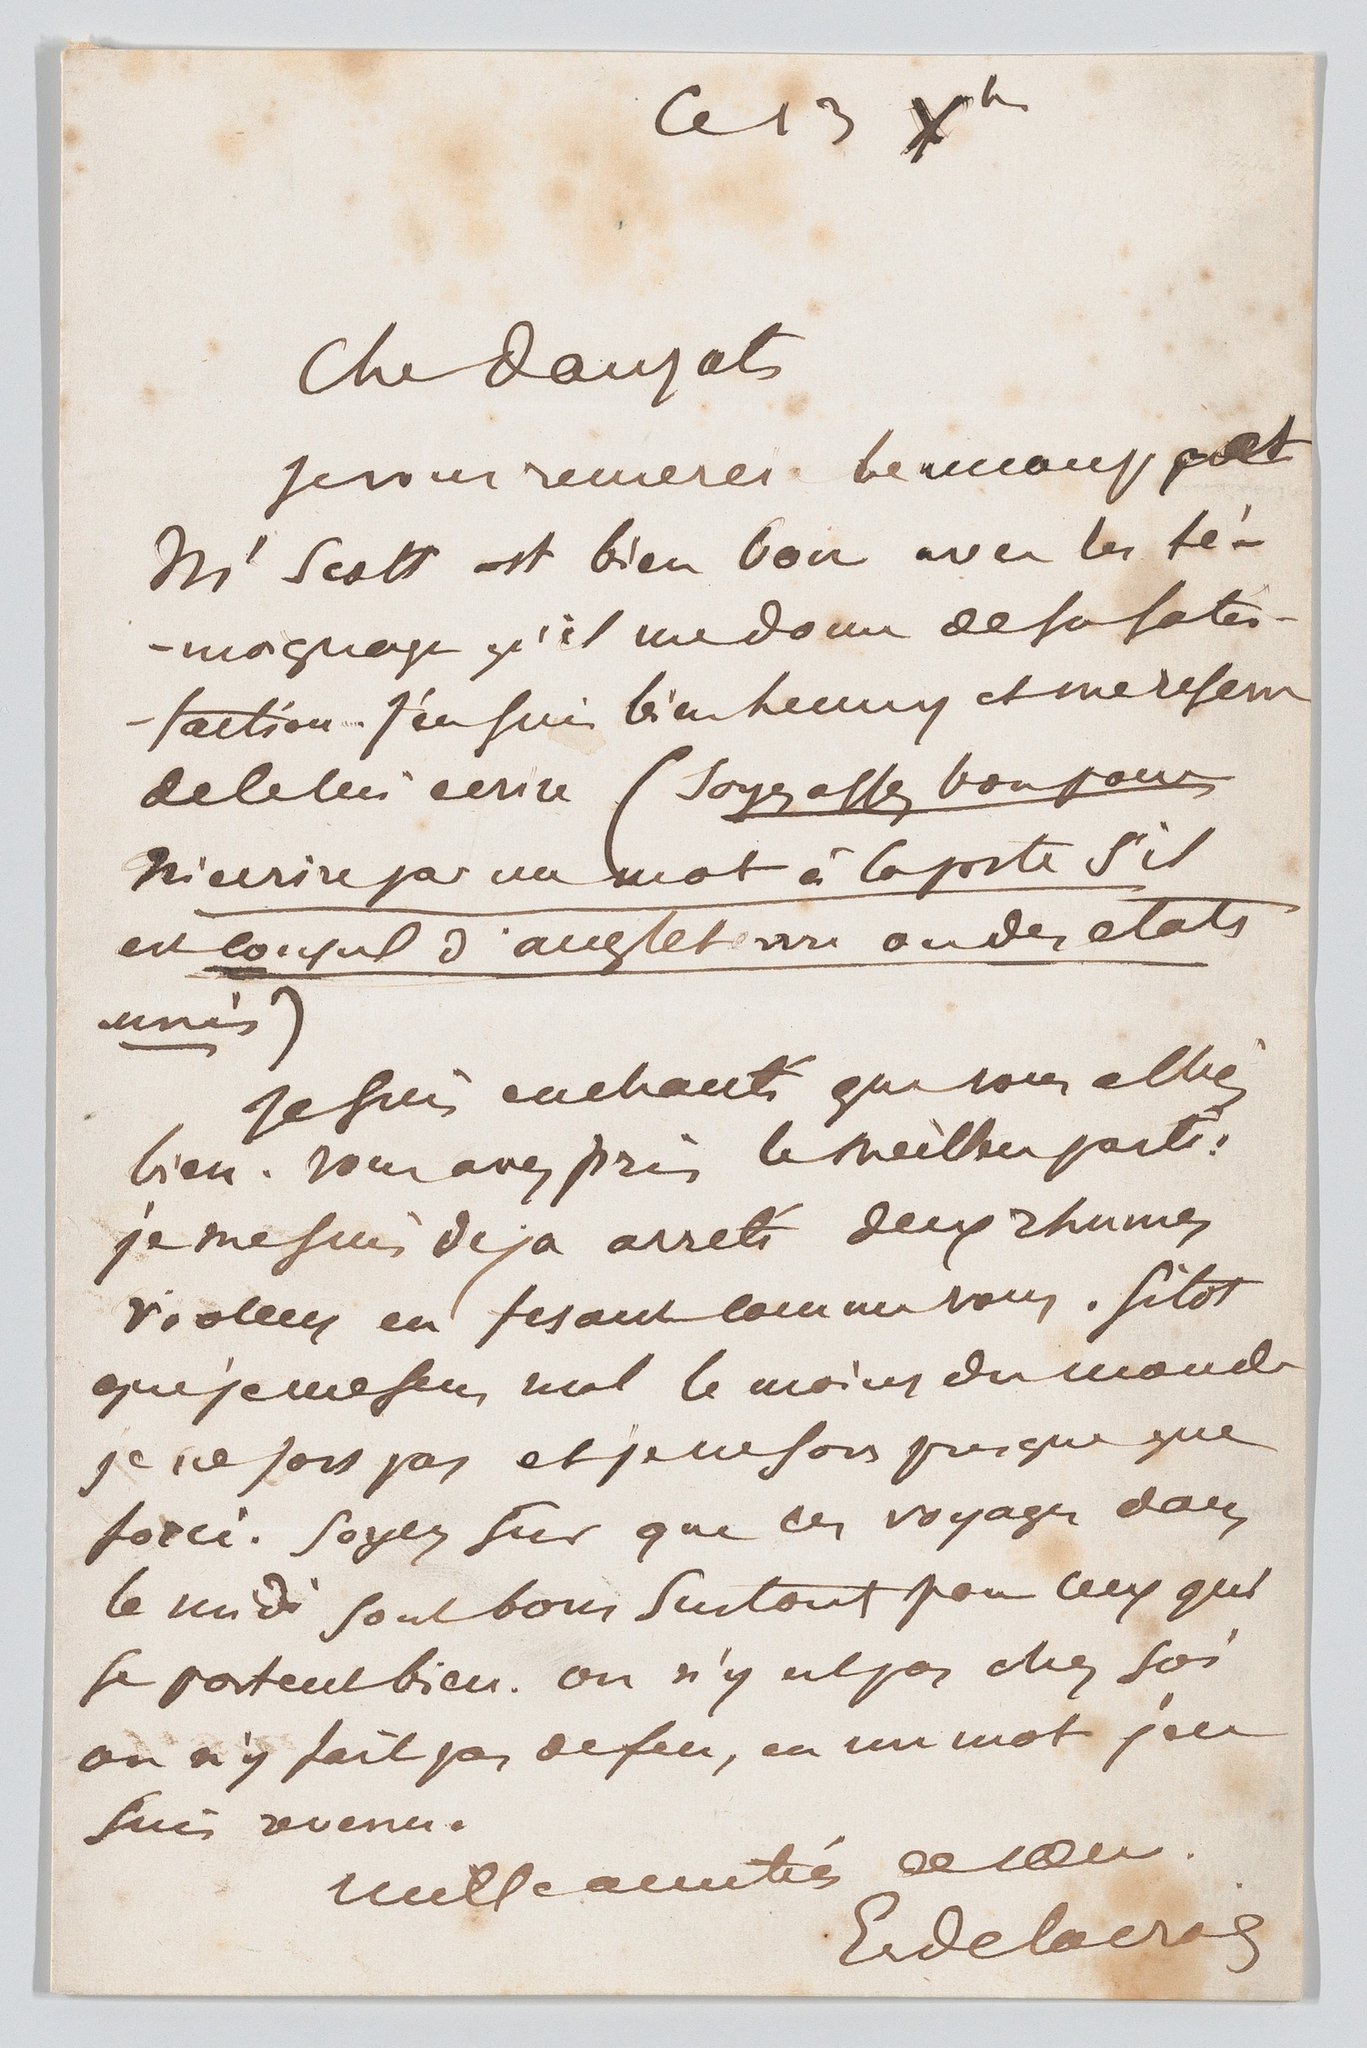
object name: drawing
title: Letter to Adrien Dauzats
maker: eugène delacroix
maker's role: artist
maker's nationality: french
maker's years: 1798-1863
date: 1845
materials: ink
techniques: pen